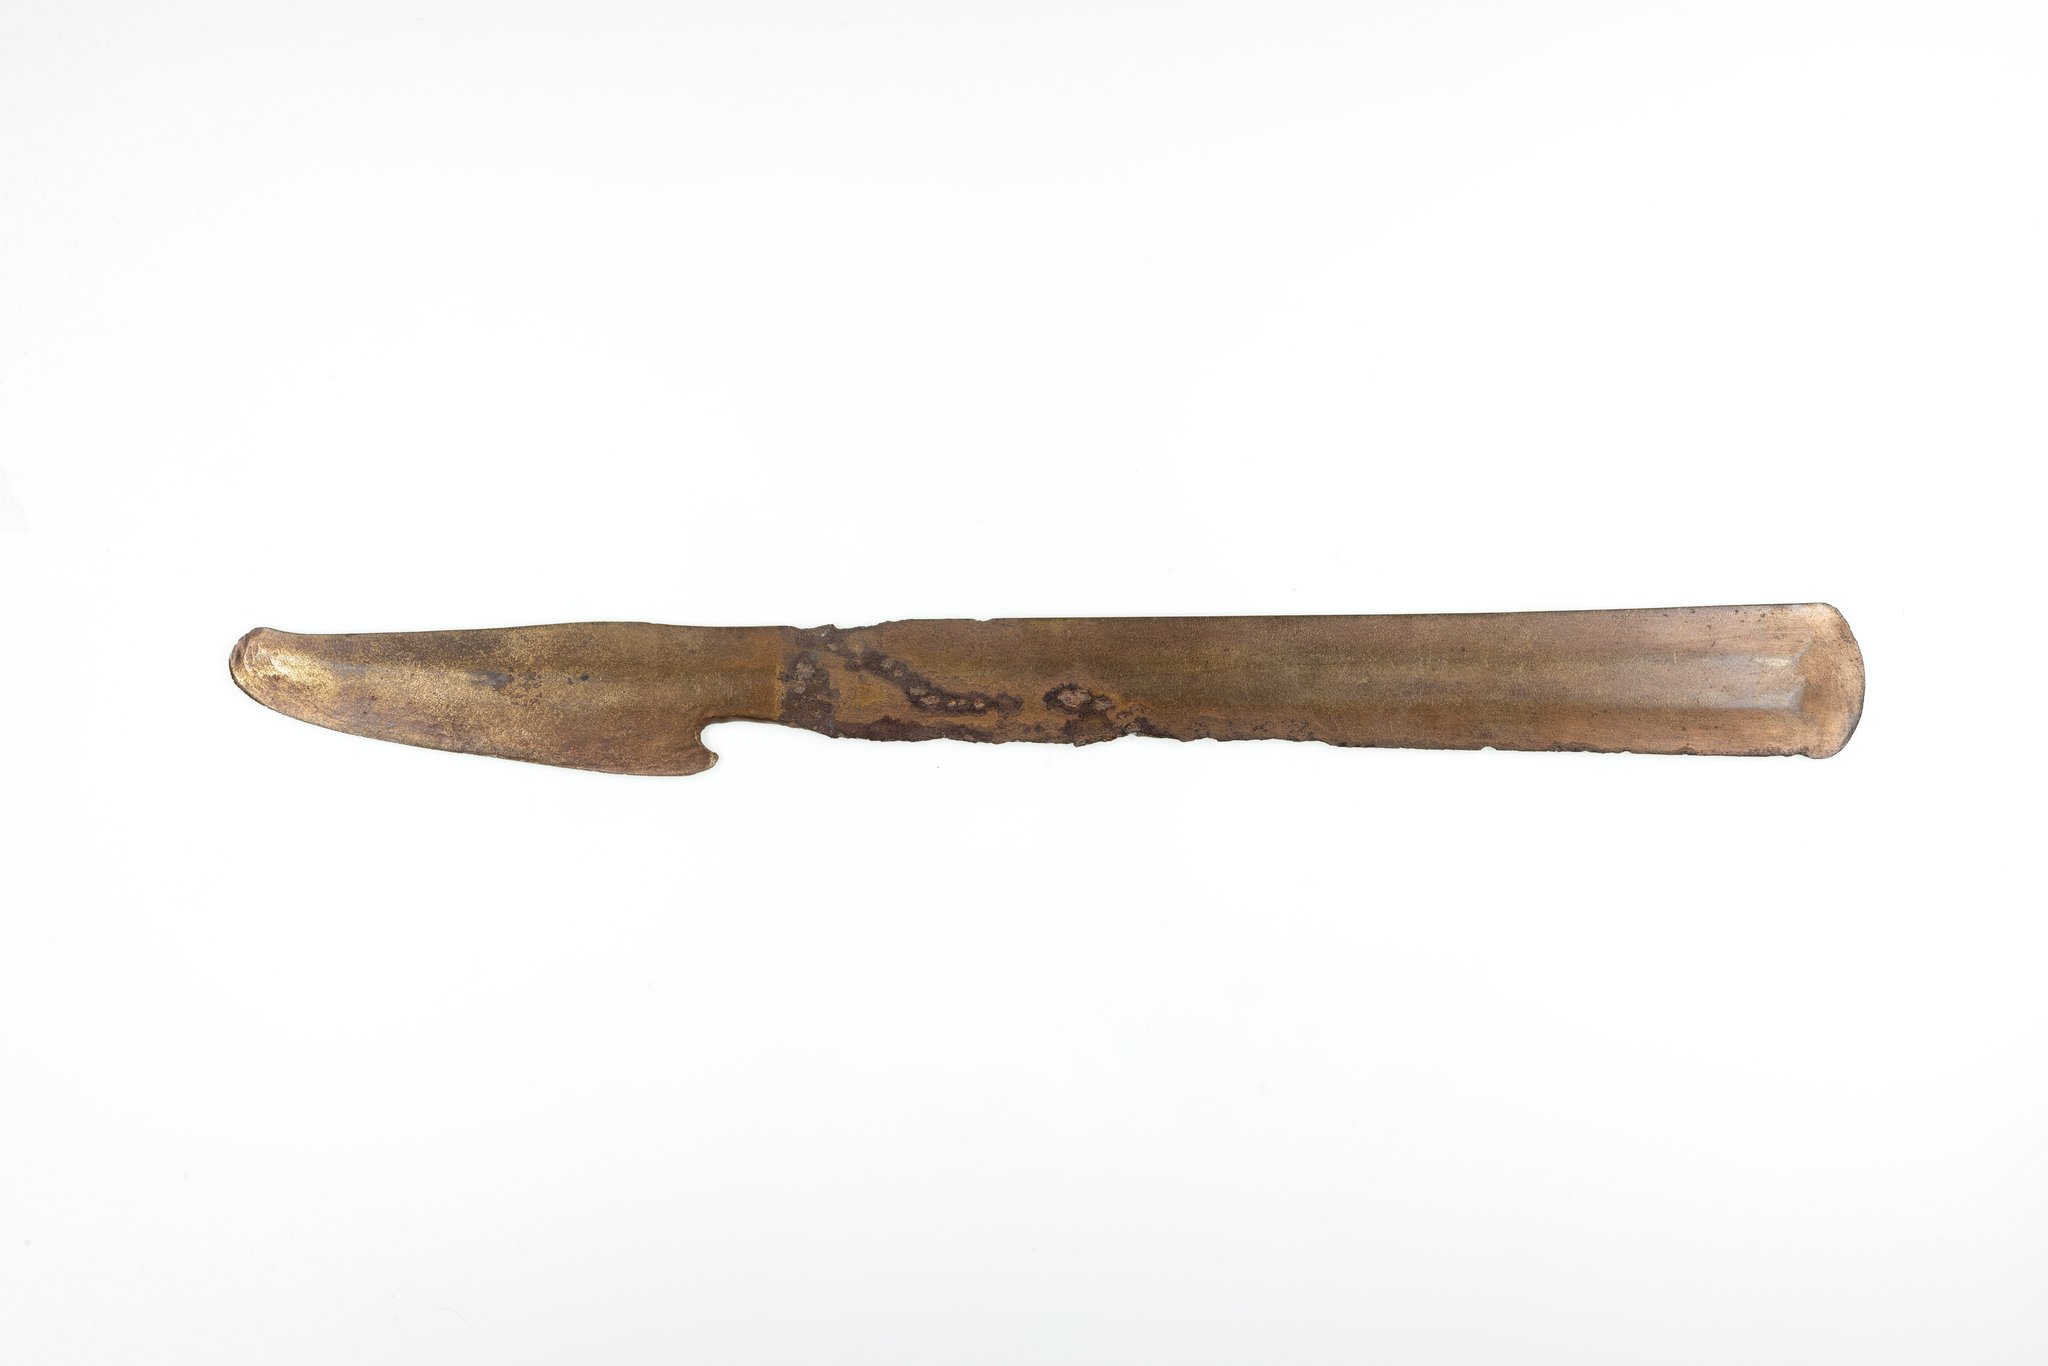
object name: razor knife, dega, baki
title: Baki's Razor-Knife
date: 1504-1447 BCE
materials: bronze, copper alloy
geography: egypt